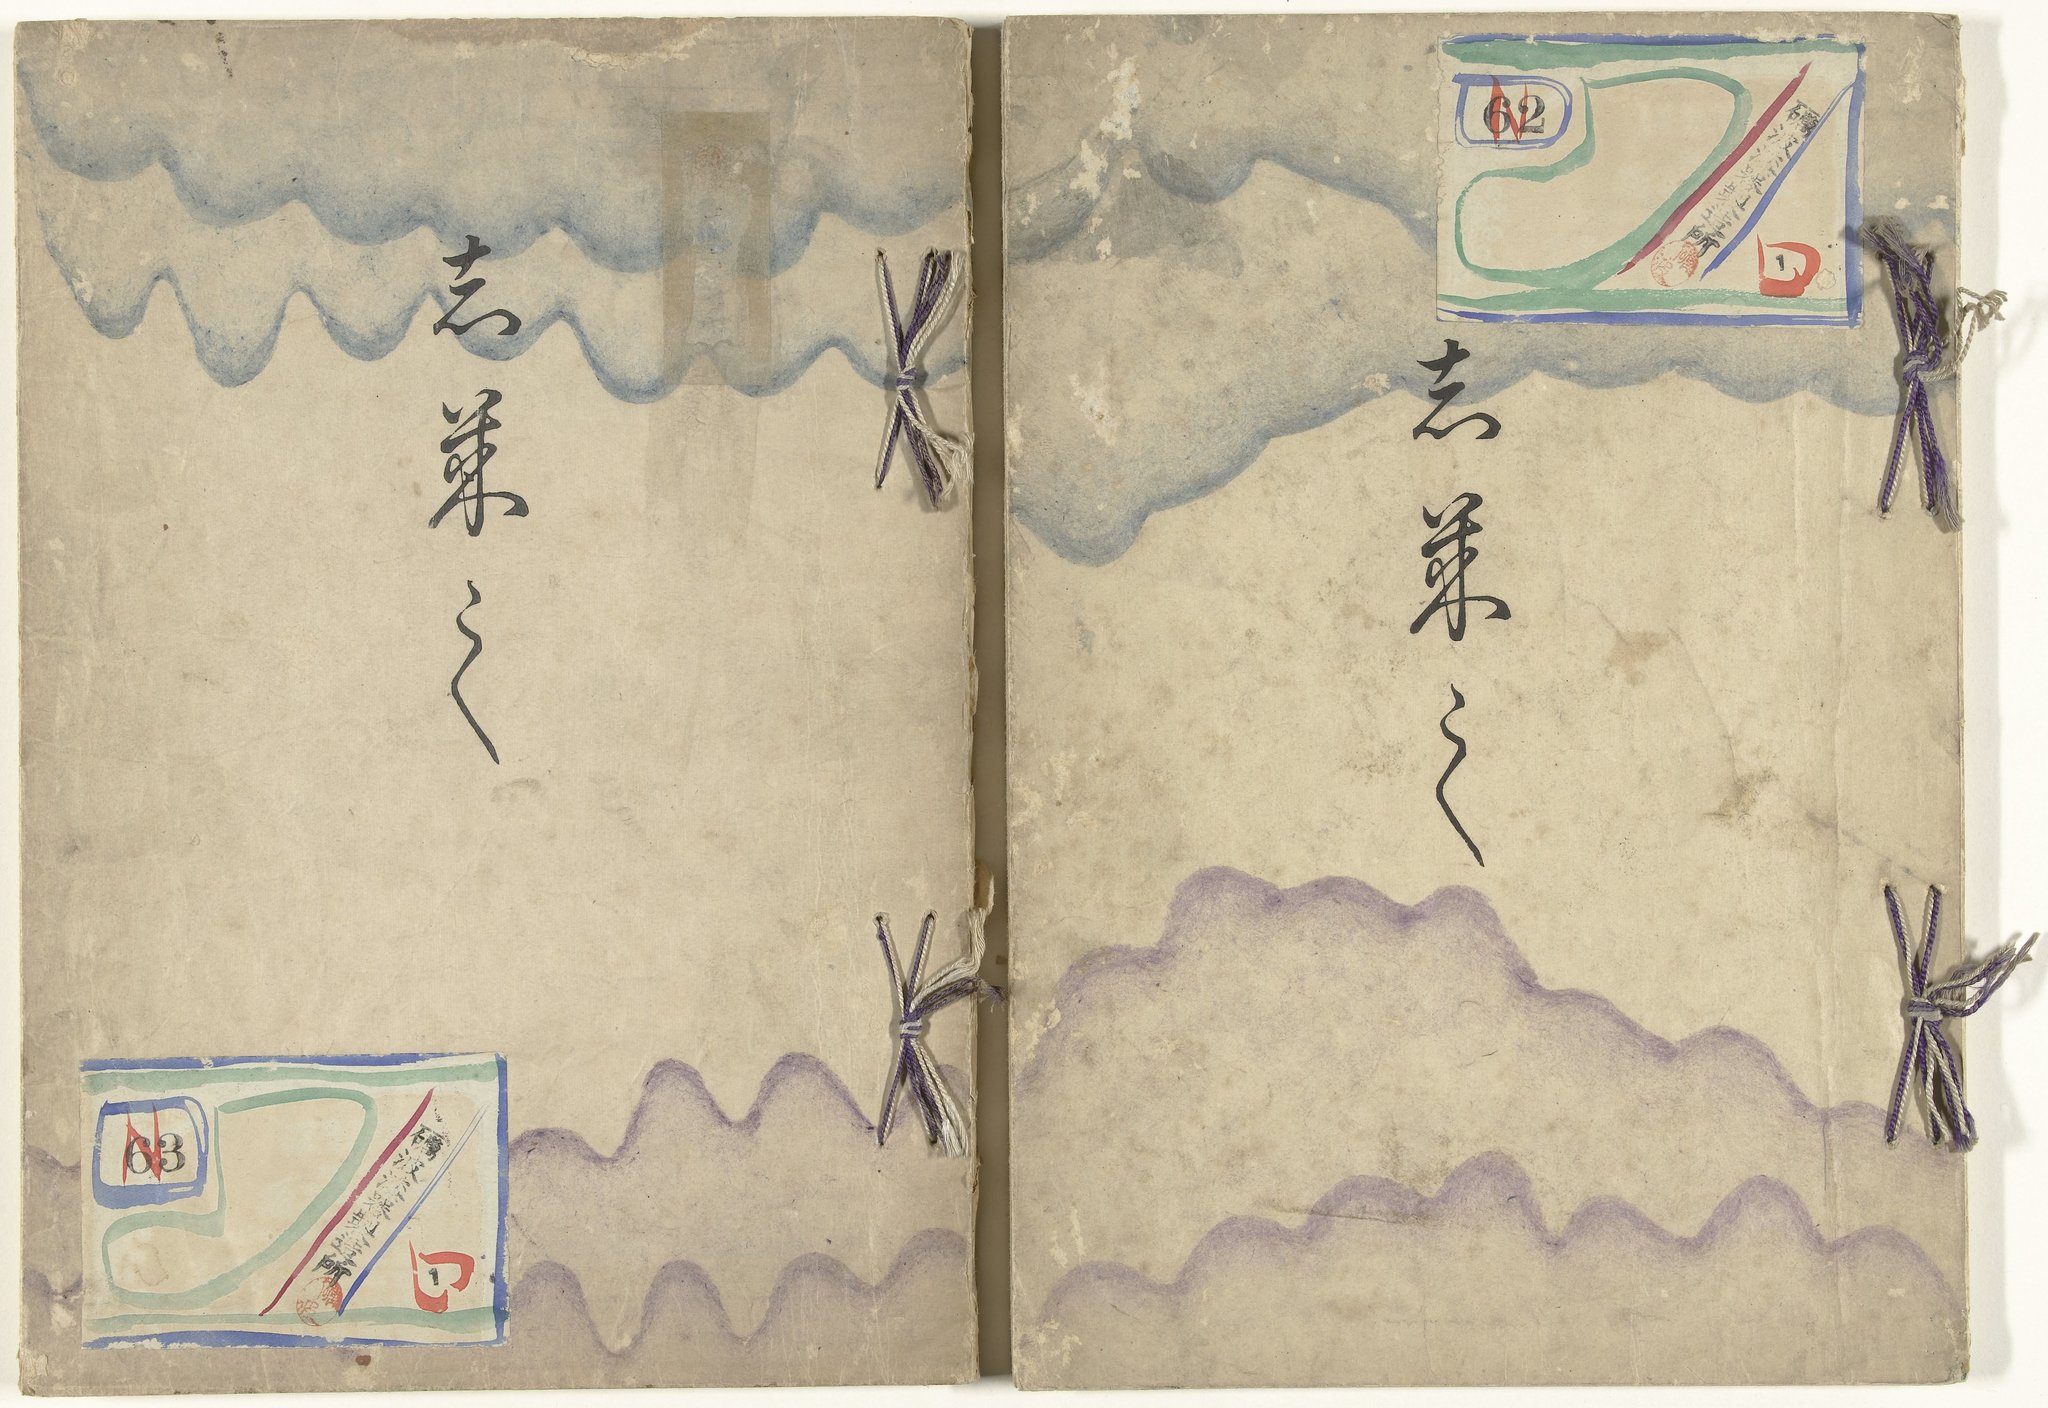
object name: book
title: Vierkante ontwerpen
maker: kamisaka sekka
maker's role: print maker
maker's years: 1866-1942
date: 1901-1902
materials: paper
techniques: woodcut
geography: kyoto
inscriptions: date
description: Twee delen (compleet); met voorstellingen van voornamelijk landschappen en vogels in vierkante kaders.